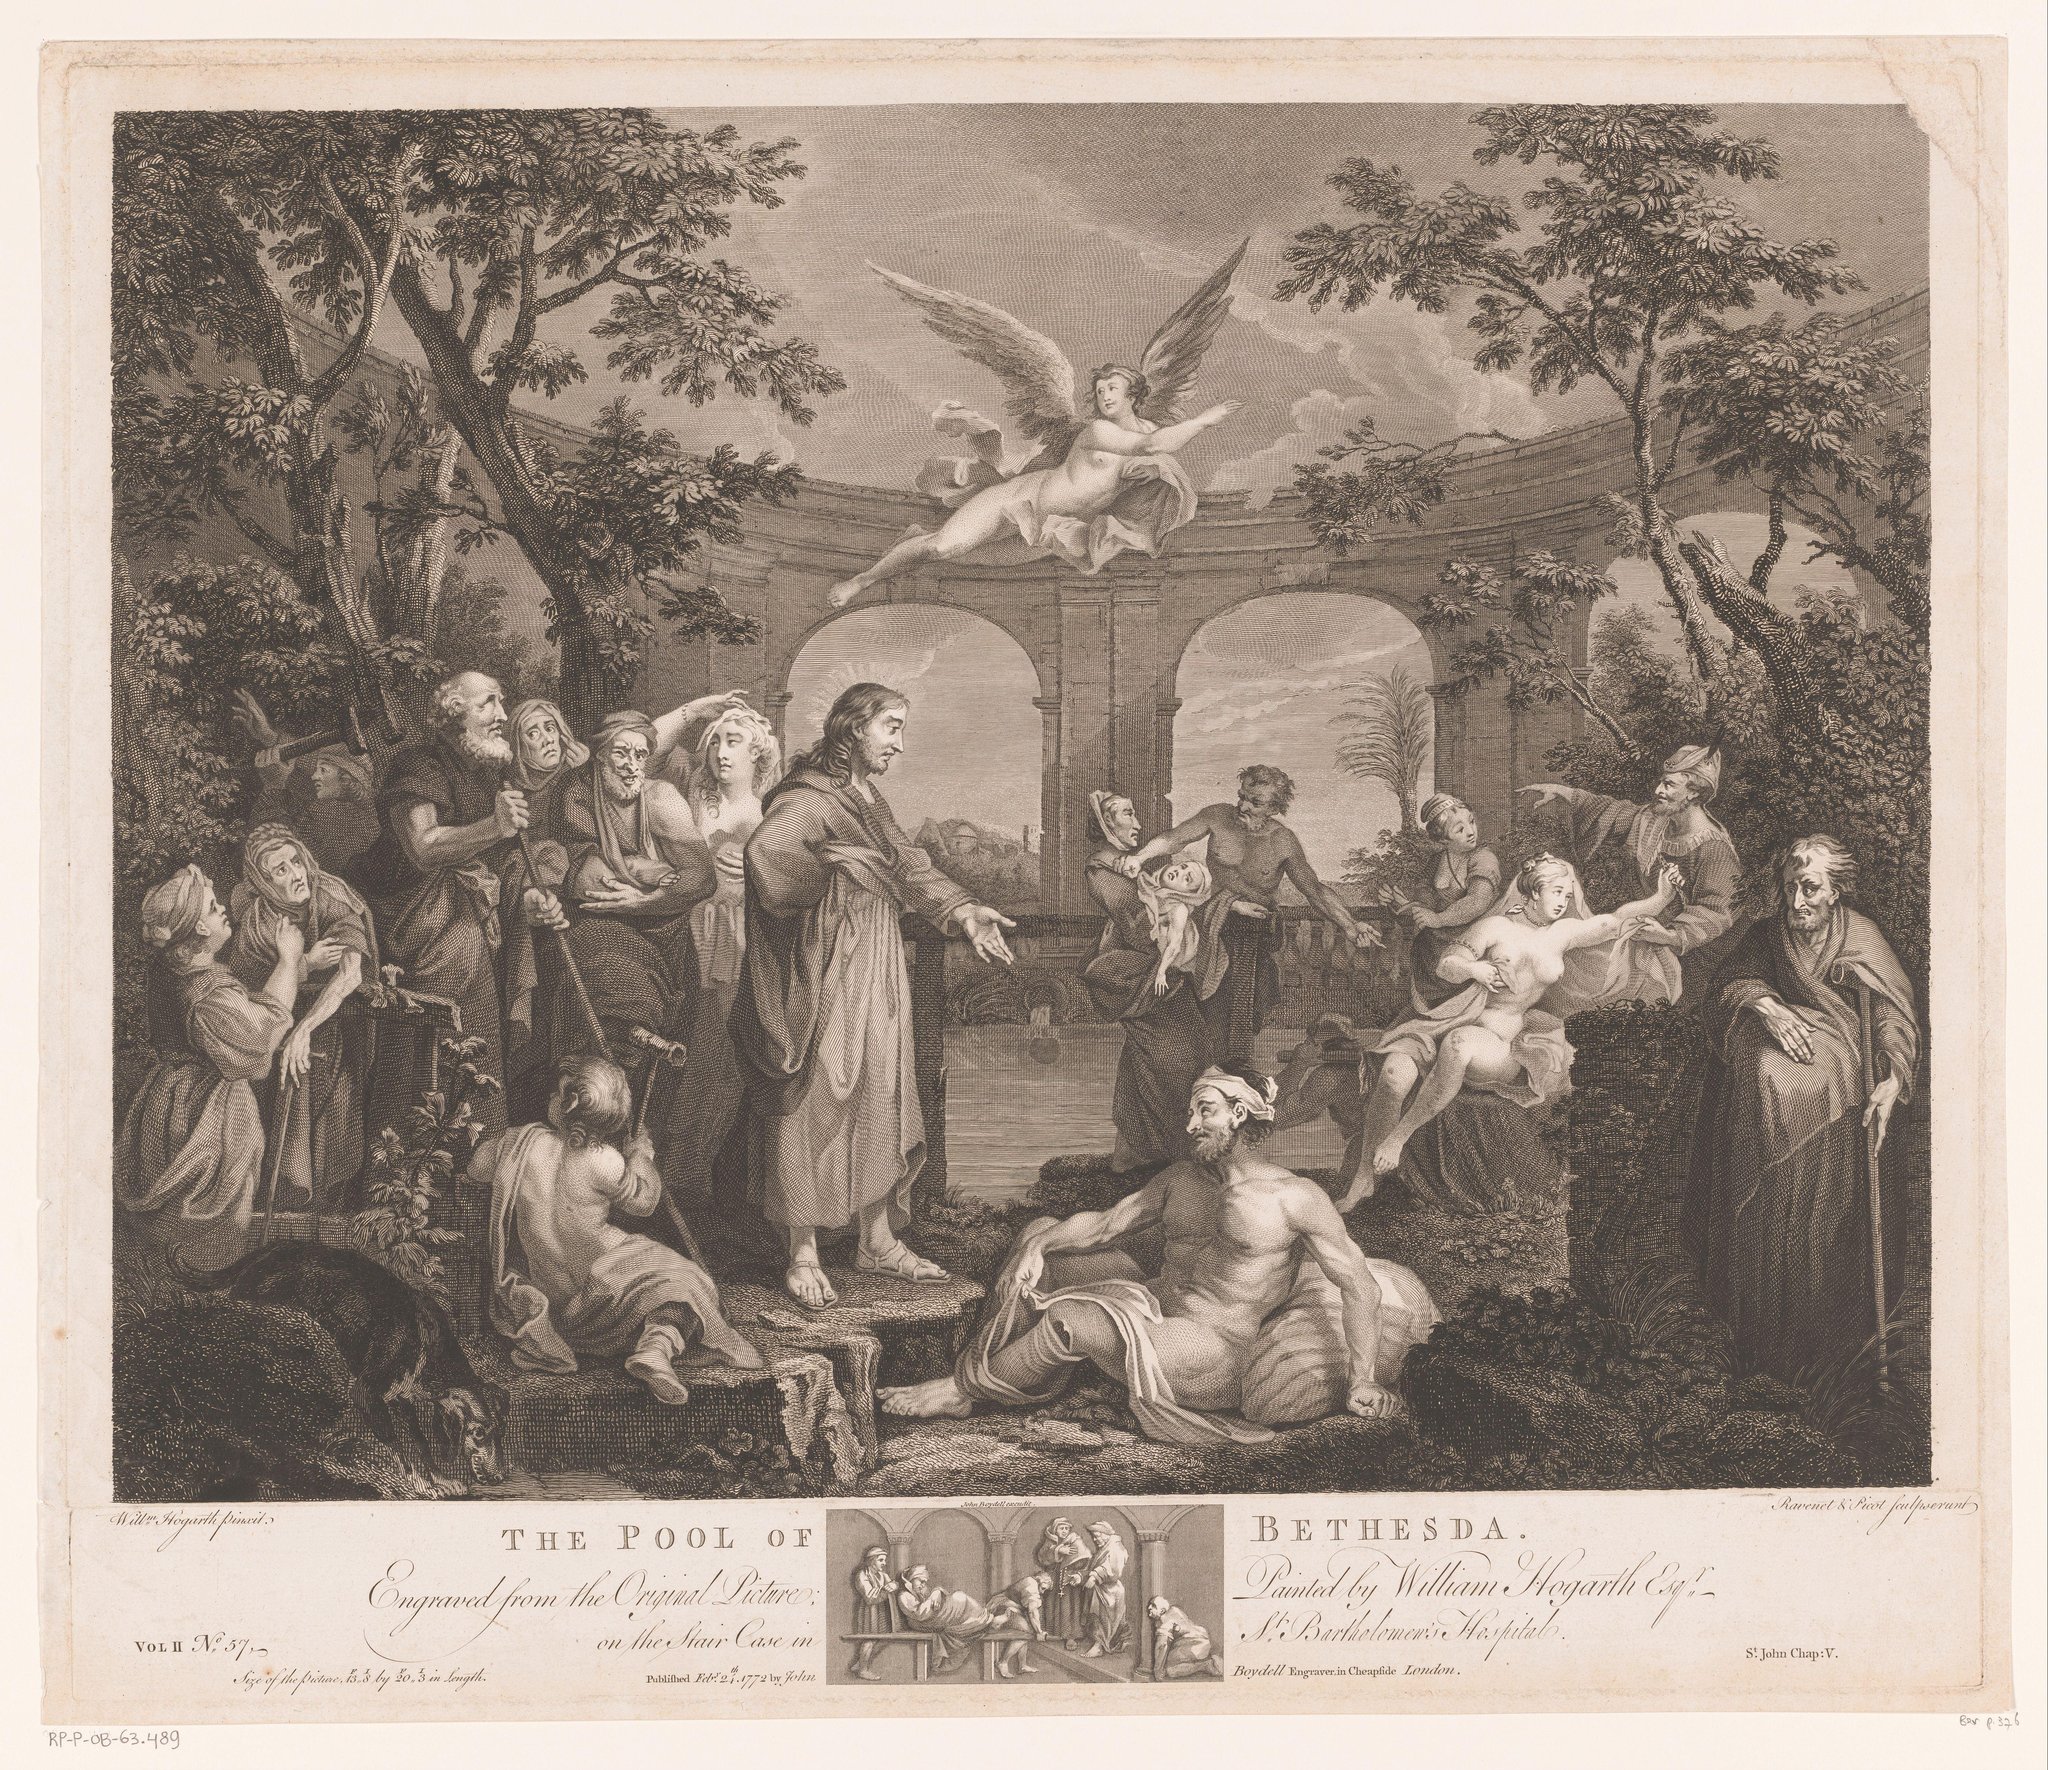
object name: print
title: Christus geneest de zieke van Bethesda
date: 1772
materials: paper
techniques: engraving, etching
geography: london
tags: sick people lying near the pool of bethesda ~ christ healing paralytics (john 5:1-9)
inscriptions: collector's mark: Lugt 2228